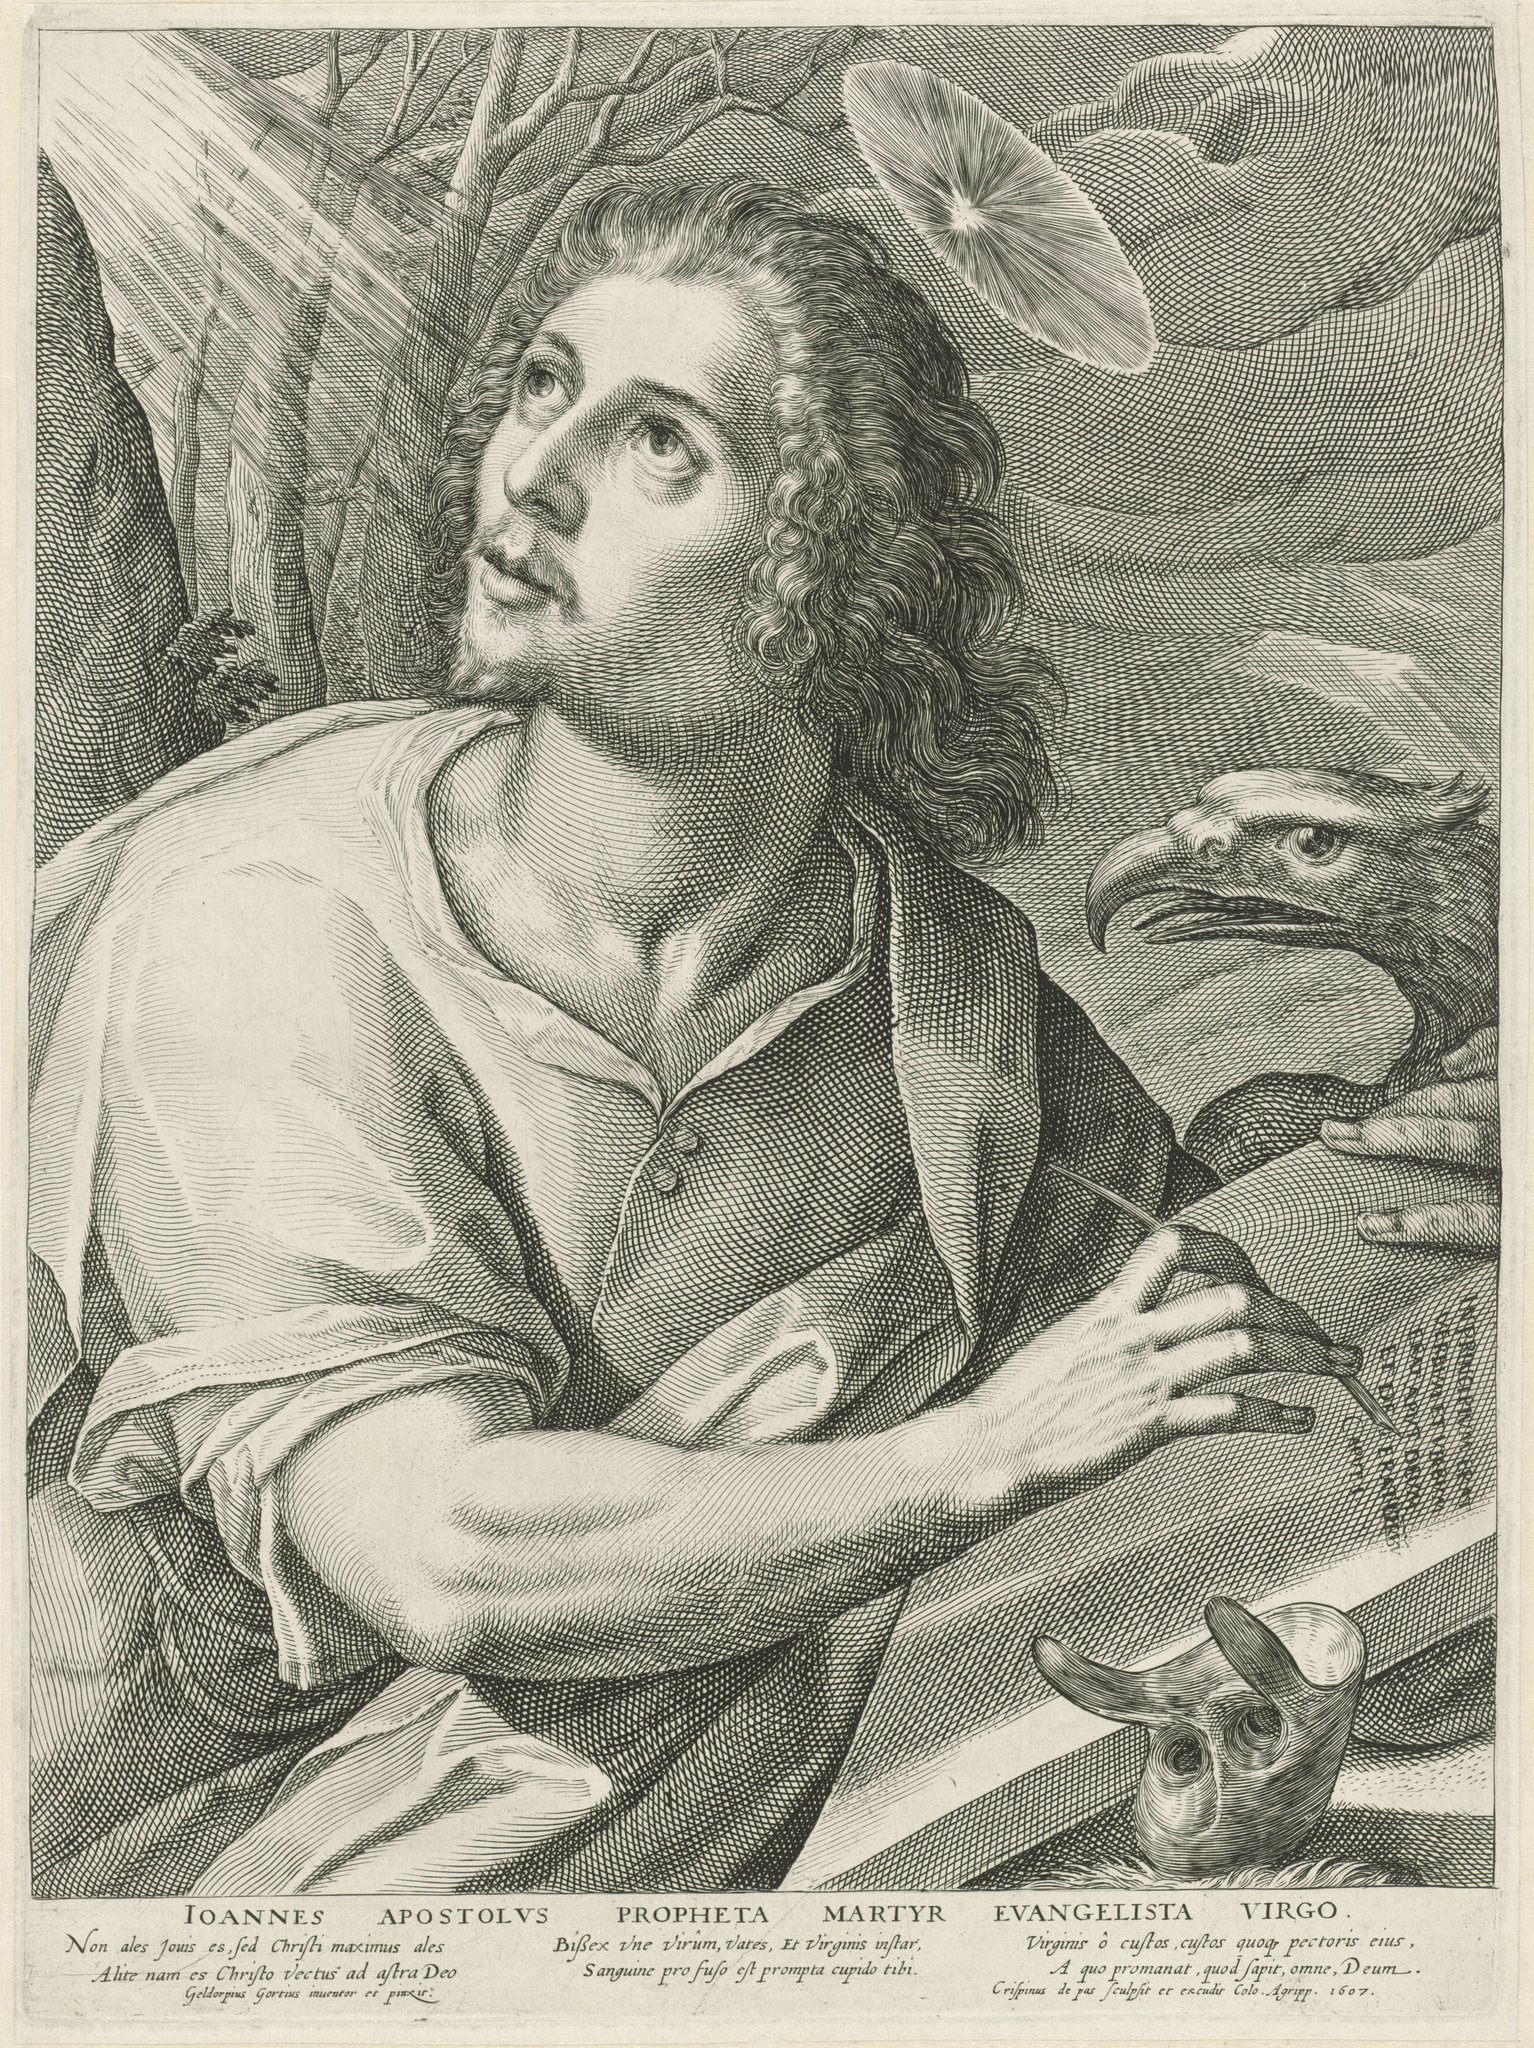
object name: print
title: Ioannes Apostolvs Propheta Martyr Evangelista Virgo.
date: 1607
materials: paper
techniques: engraving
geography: cologne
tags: st. john the evangelist writing the gospel, usually the eagle present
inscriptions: collector's mark: Lugt 2166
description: Buste van de evangelist Johannes die zijn evangelie schrijft. Naast hem zijn attribuut de adelaar. In de marge een zesregelig onderschrift, in drie kolommen, in het Latijn. Prent uit een serie van vier met de evangelisten.